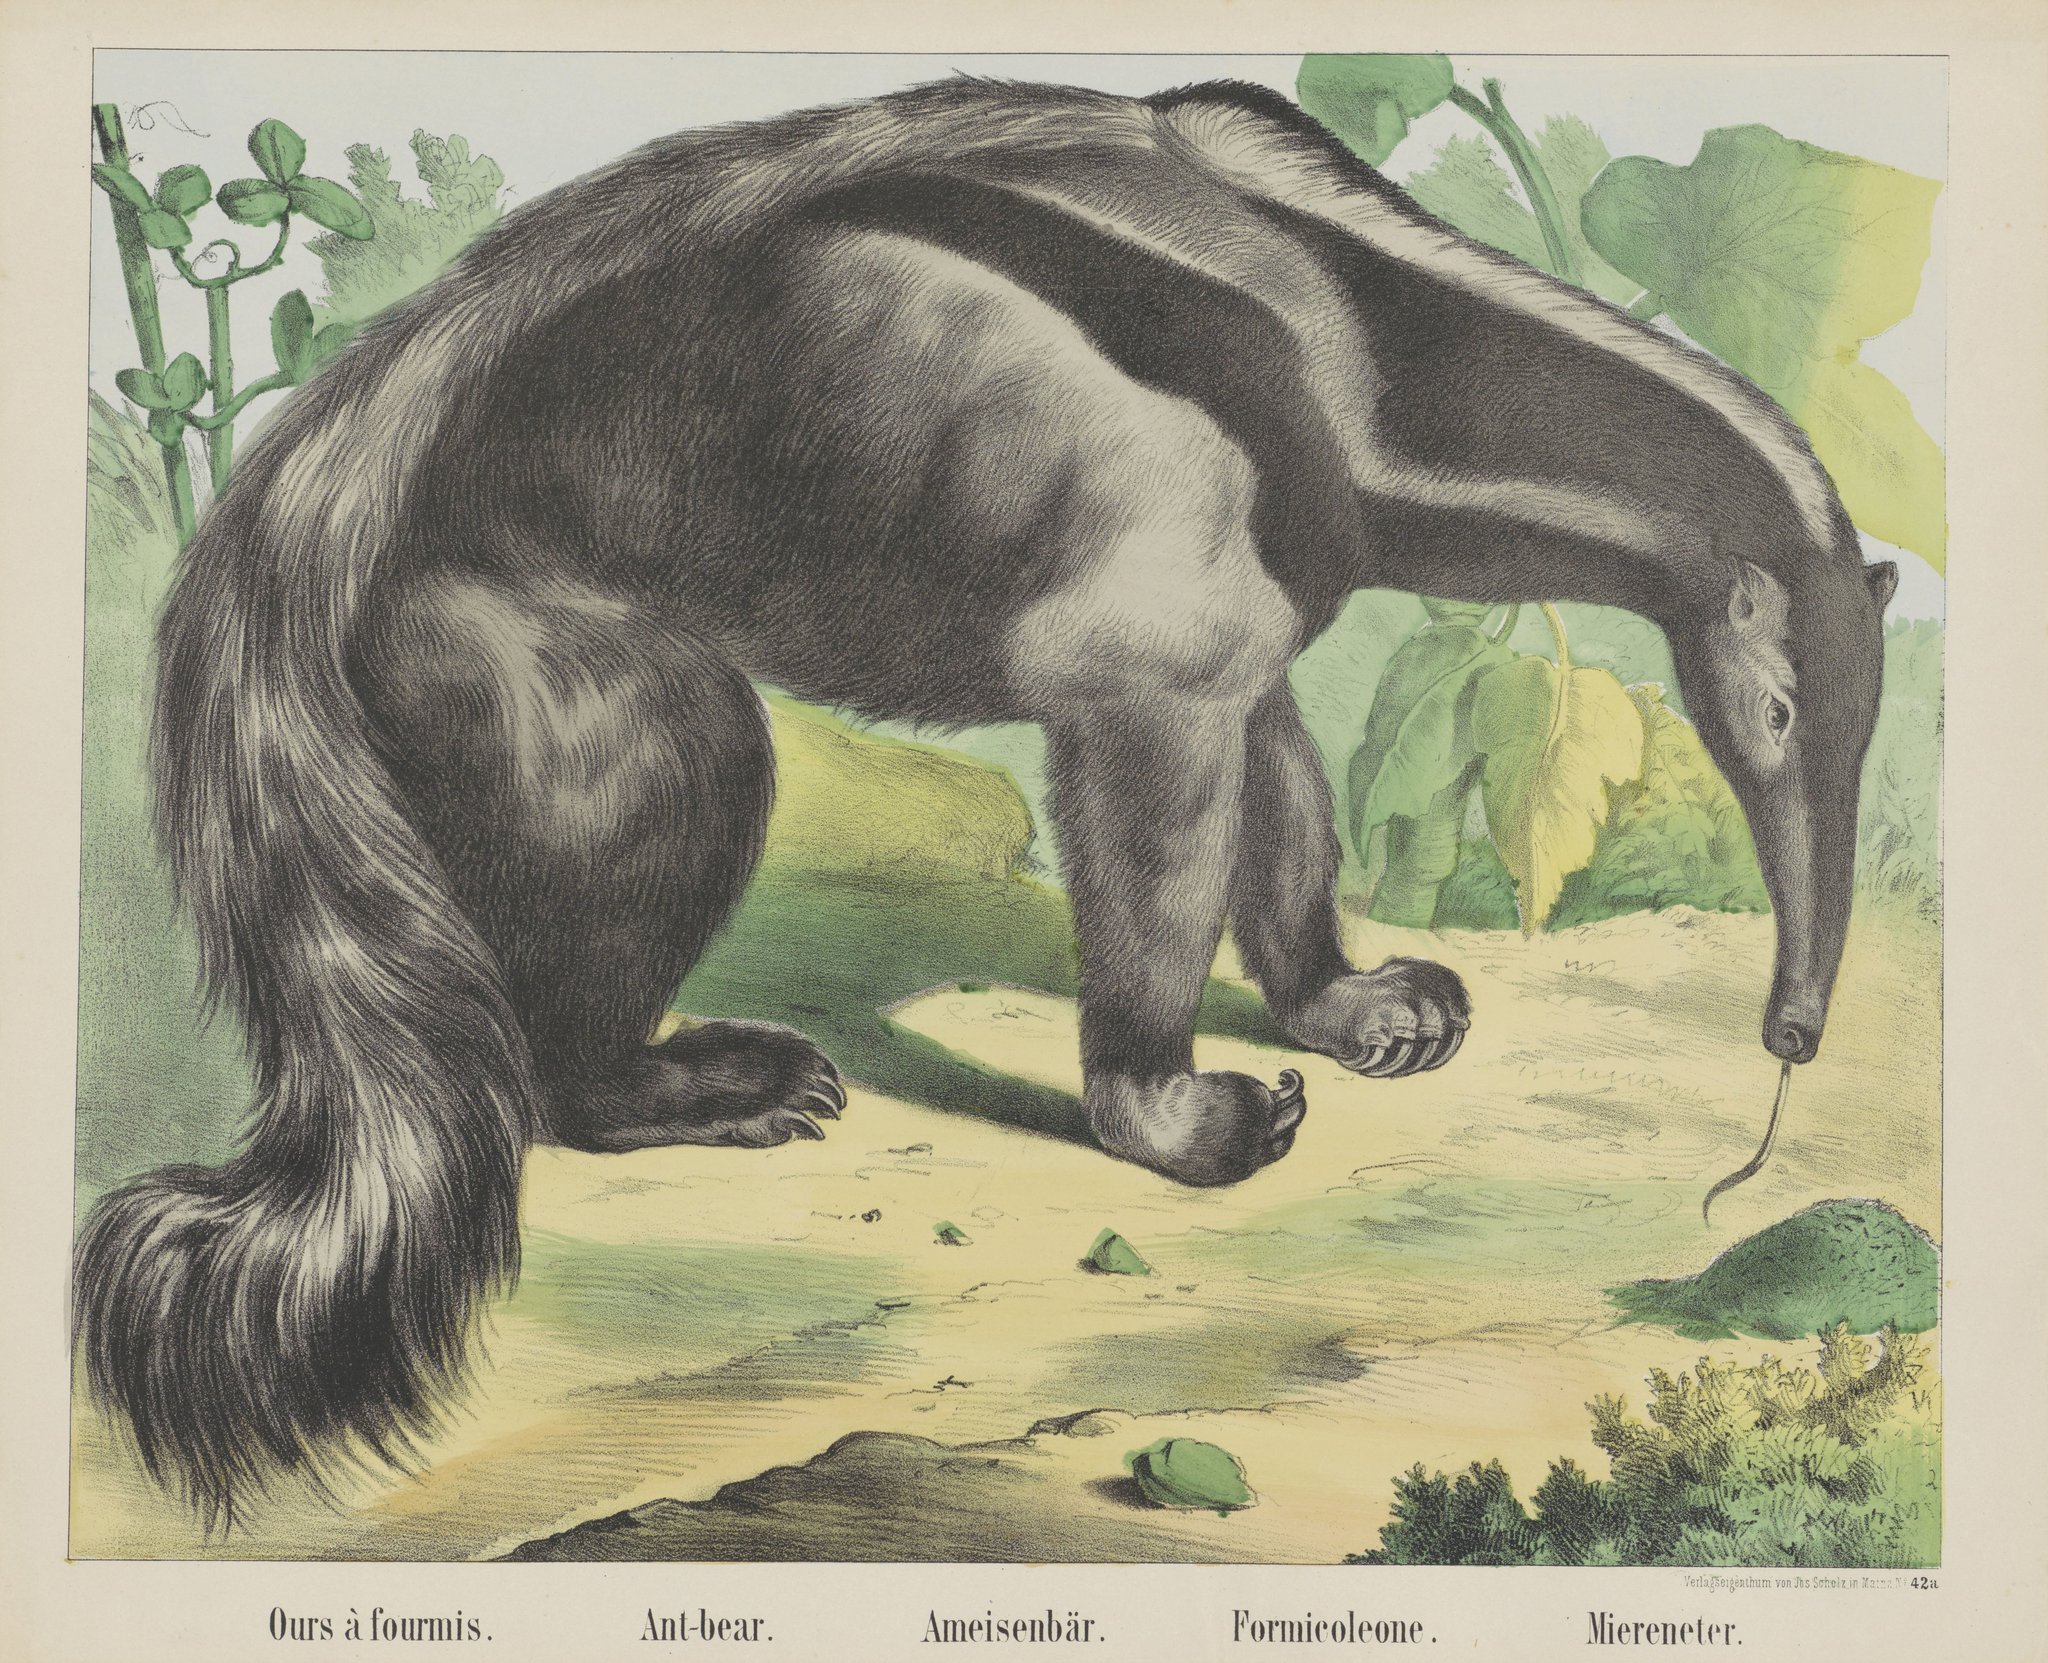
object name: print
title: Ours à fourmis. / Ant-bear. / Ameisenbär. / Formicoleone. / Miereneter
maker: Anonymous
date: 1829-1880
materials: paper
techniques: colour, letterpress printing, lithograph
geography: mainz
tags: other mammals (with name)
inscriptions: collector's mark: Lugt 2760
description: Miereneter tussen planten. Genummerd rechtsonder: No. 42a.